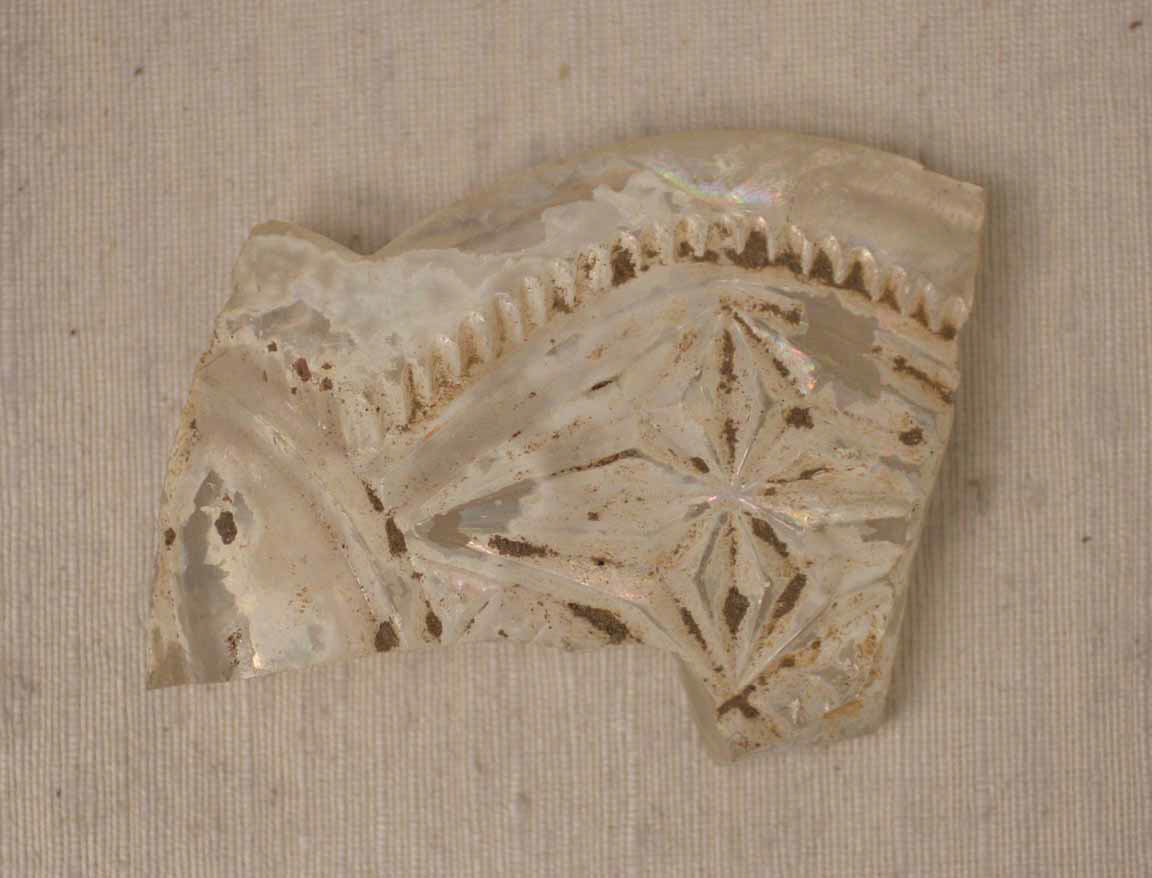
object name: fragment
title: Glass Fragment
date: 801-1200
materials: glass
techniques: cutting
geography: egypt